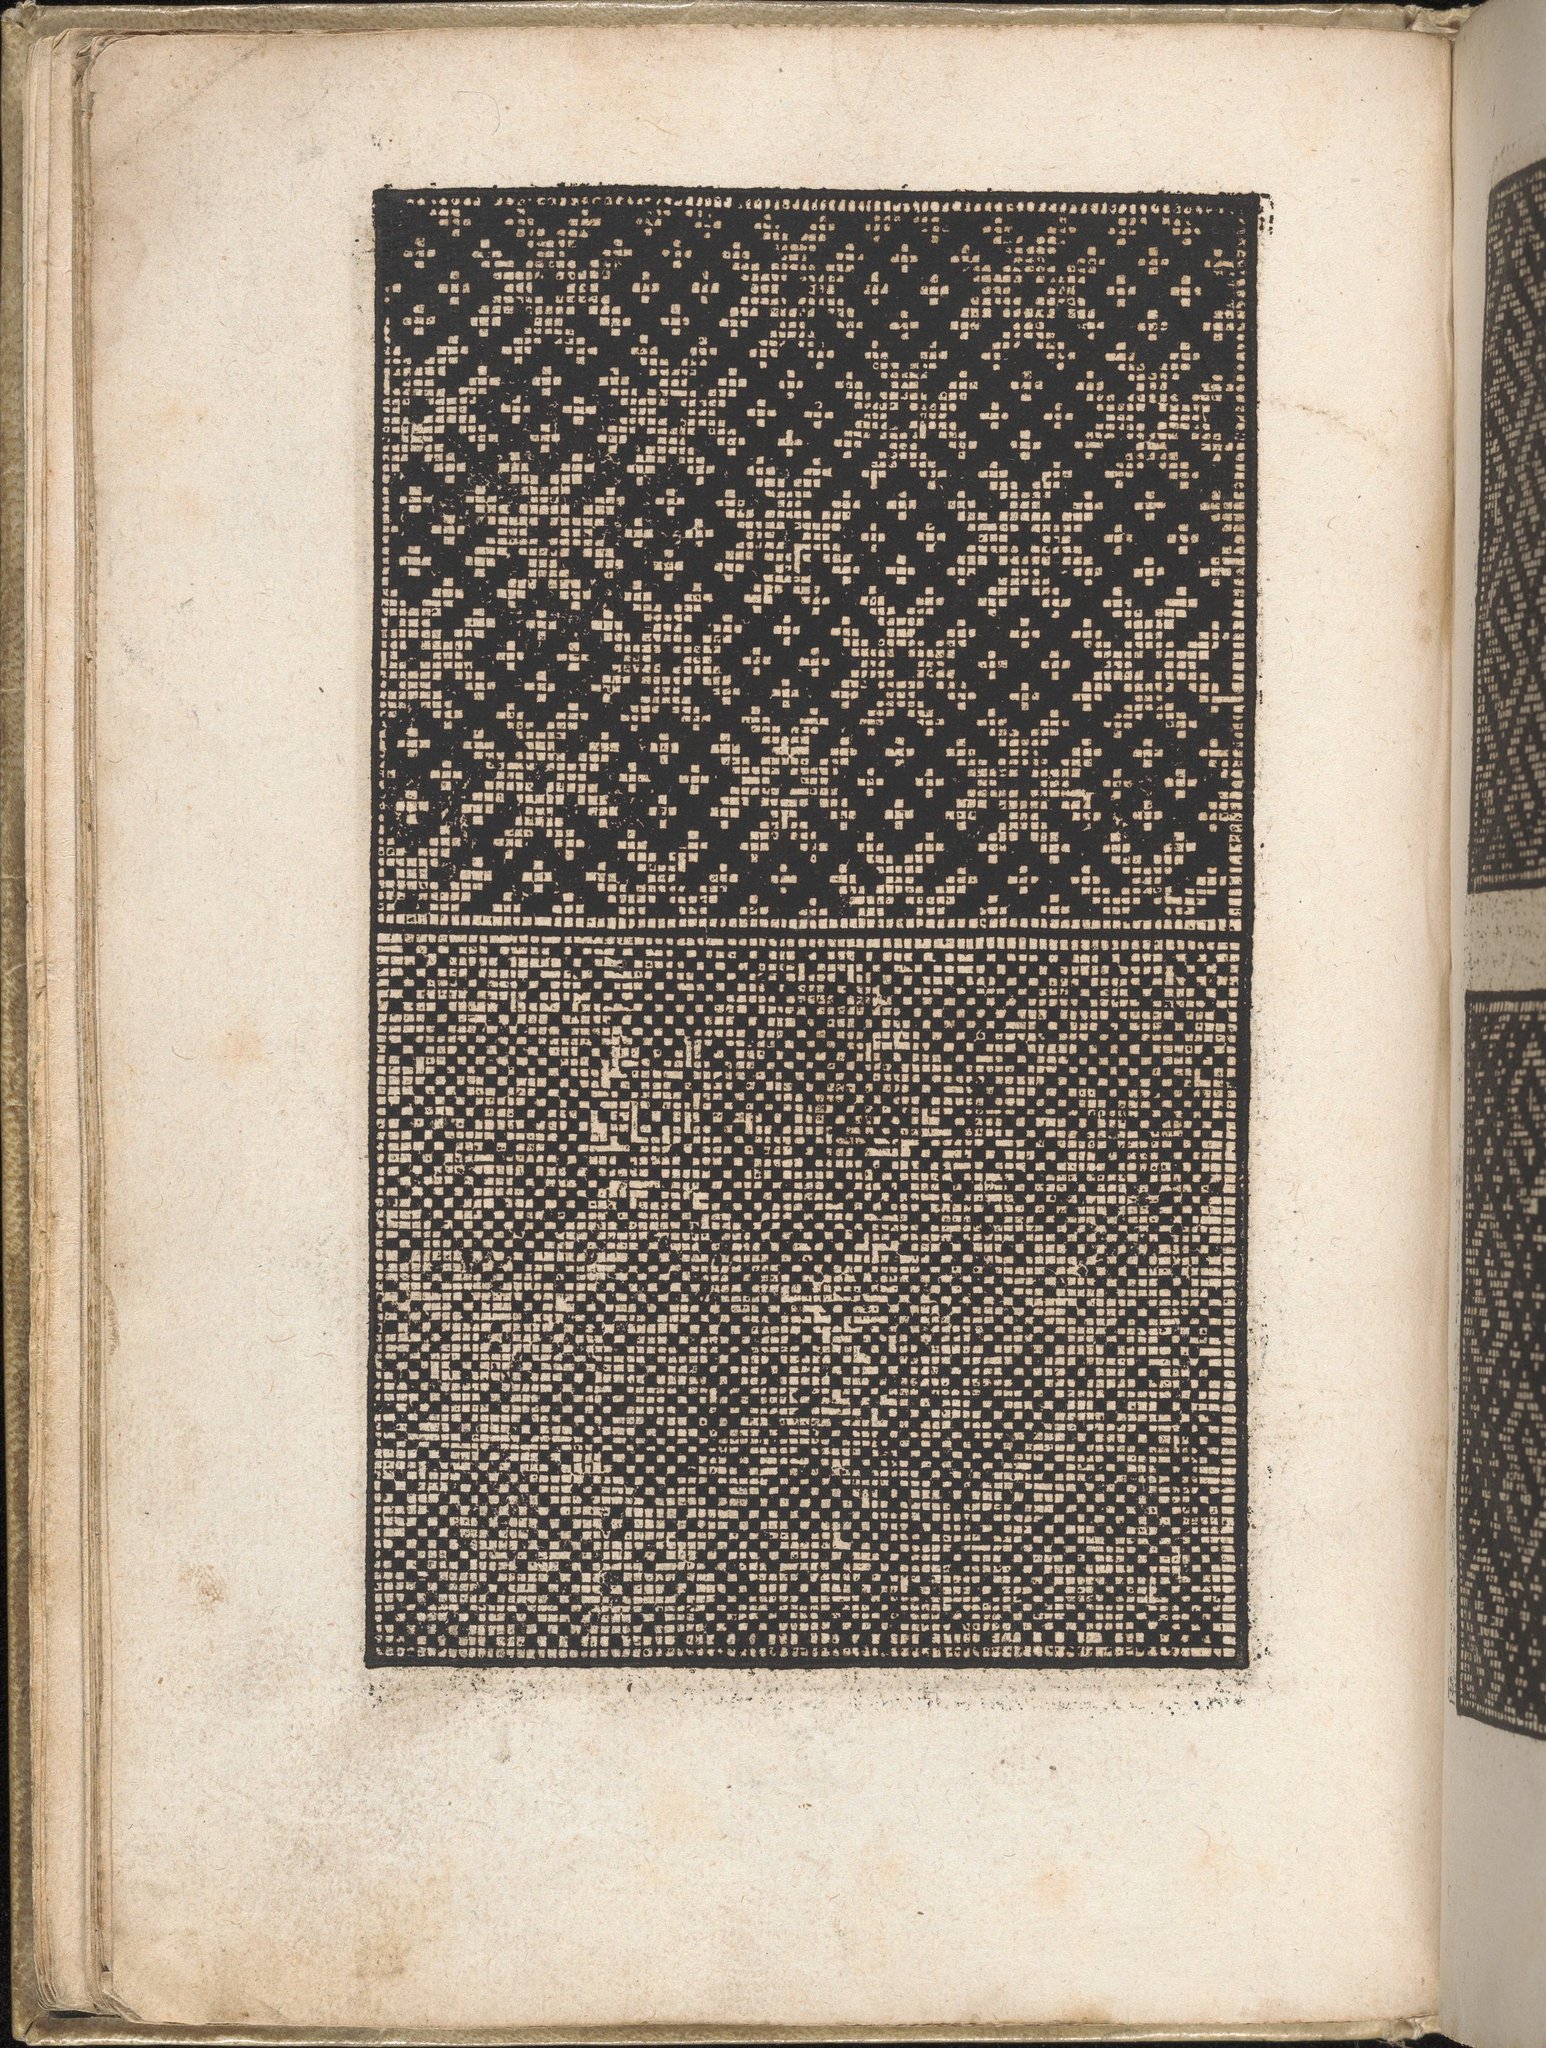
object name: book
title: Page 18r, from "Eyn New Kunstlichboich"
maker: peter quentel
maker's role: publisher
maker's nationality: german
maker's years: 1500-1550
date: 1529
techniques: woodcut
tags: ornament